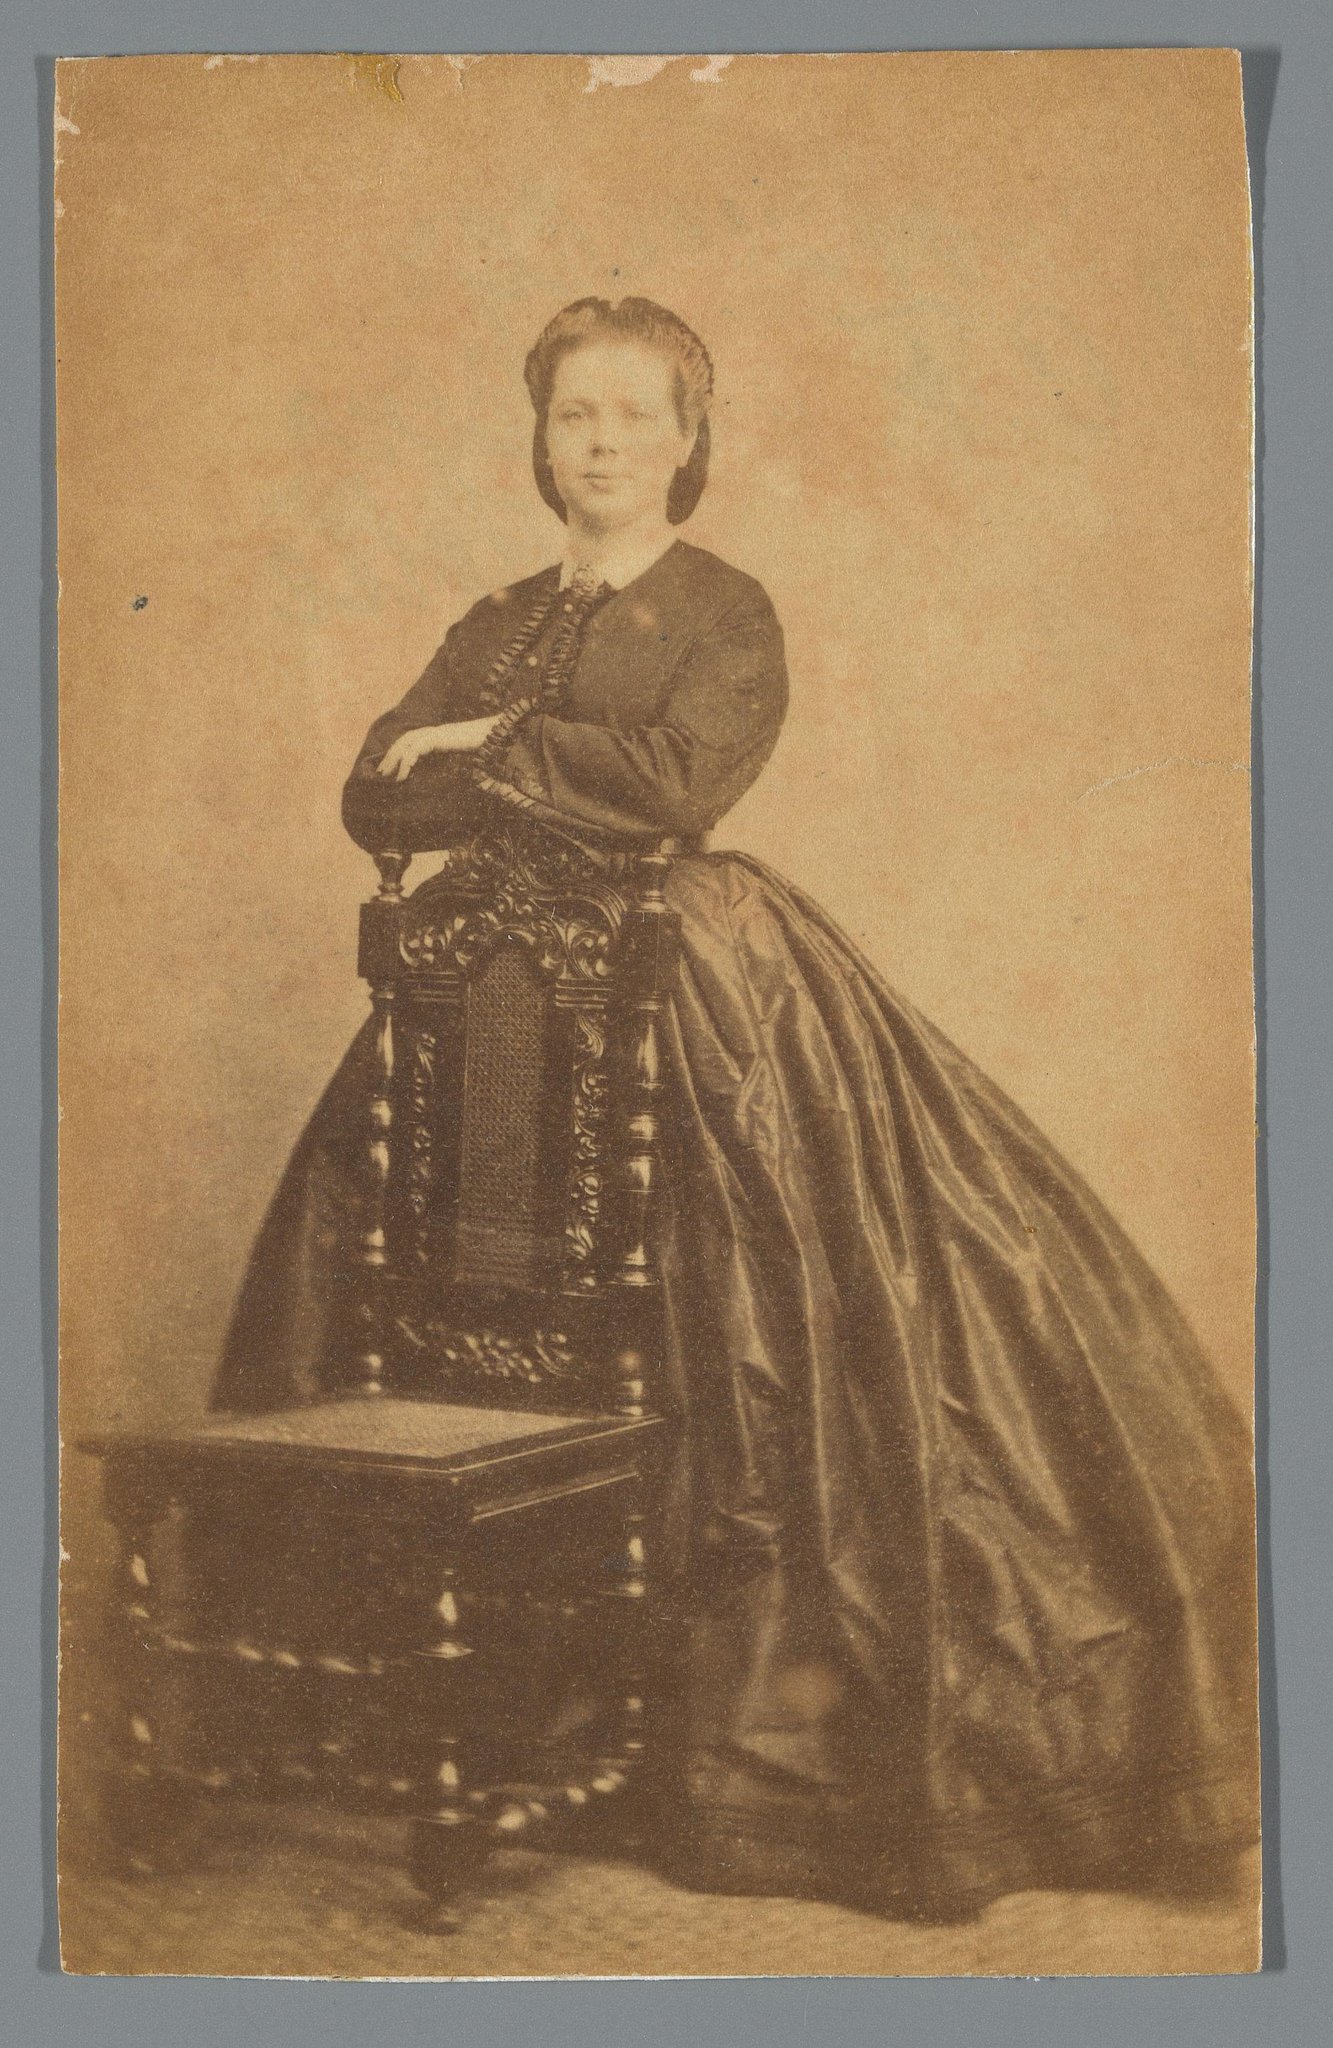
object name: photograph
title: Staand studioportret van Carolina Frederika Holle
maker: Anonymous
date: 1860-1889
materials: photographic support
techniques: photography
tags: amsterdam, carolina frederika van den berg-holle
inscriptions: name: ‘C.F. van den Berg- / Holle’